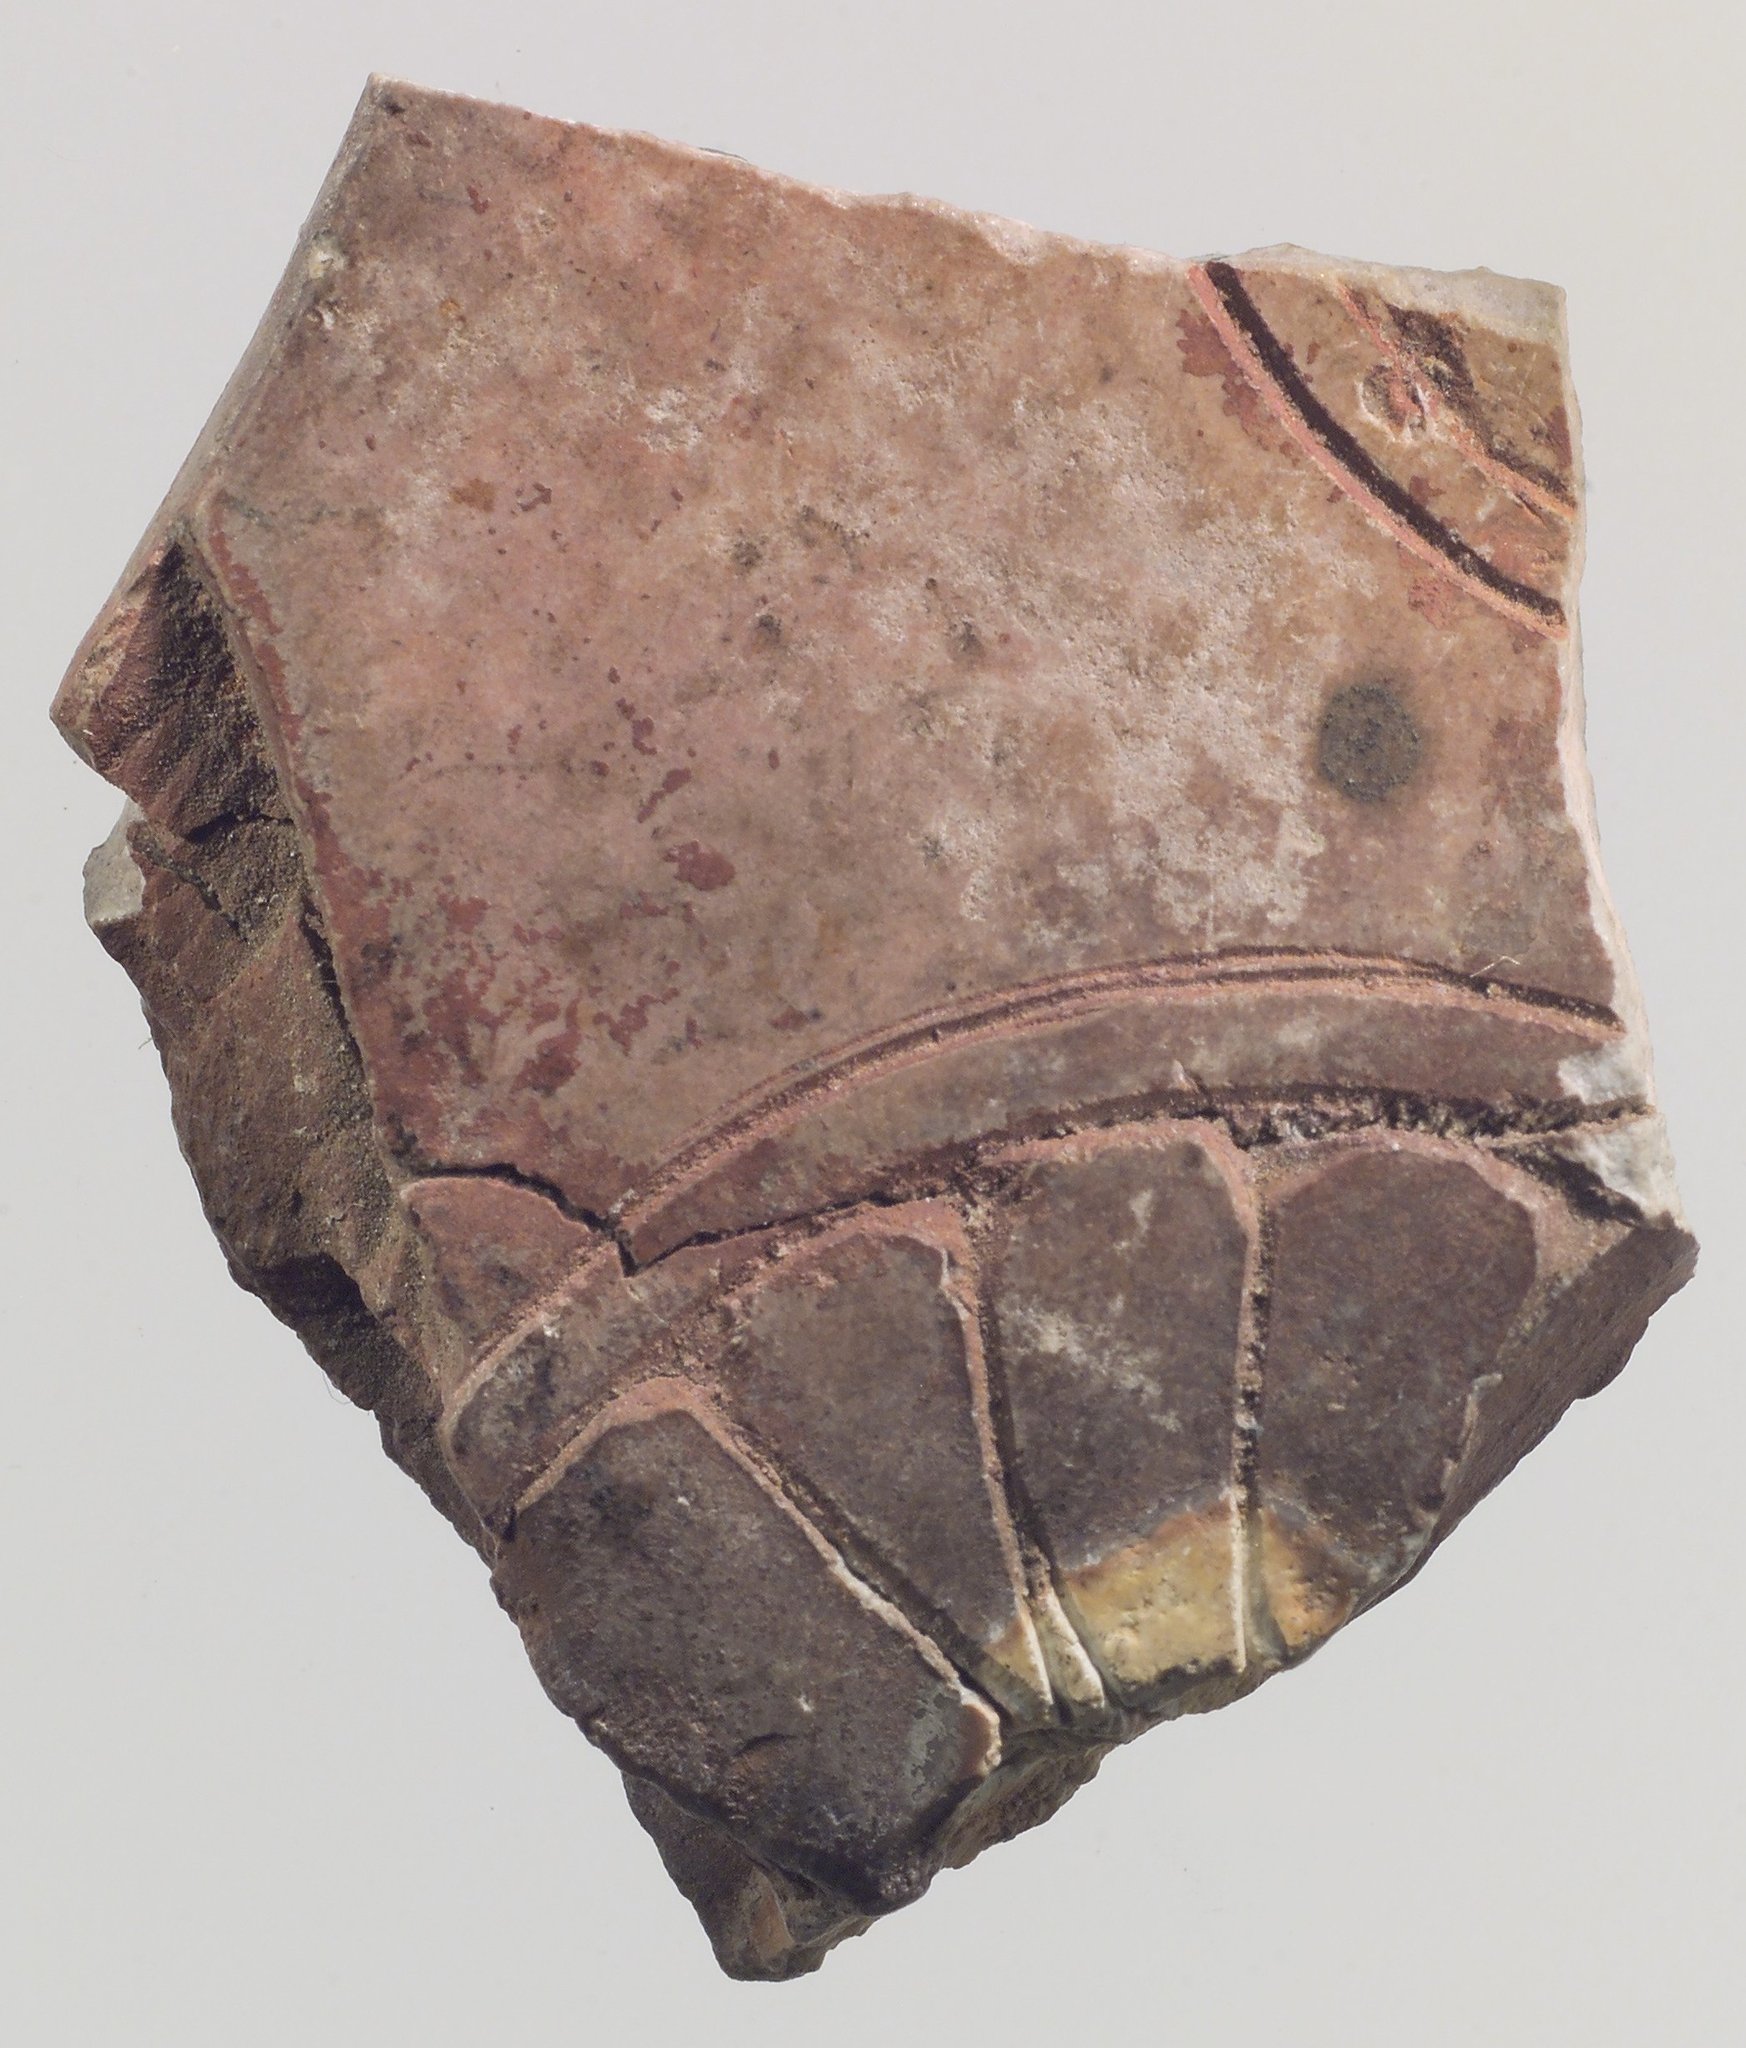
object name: furniture element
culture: assyrian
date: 1800-1701 BCE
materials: ivory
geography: anatolia